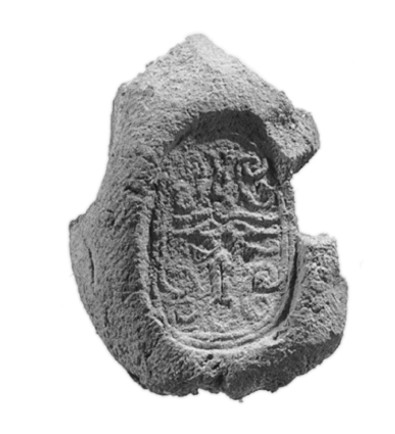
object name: sealing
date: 2030-1640 BCE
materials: clay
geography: egypt